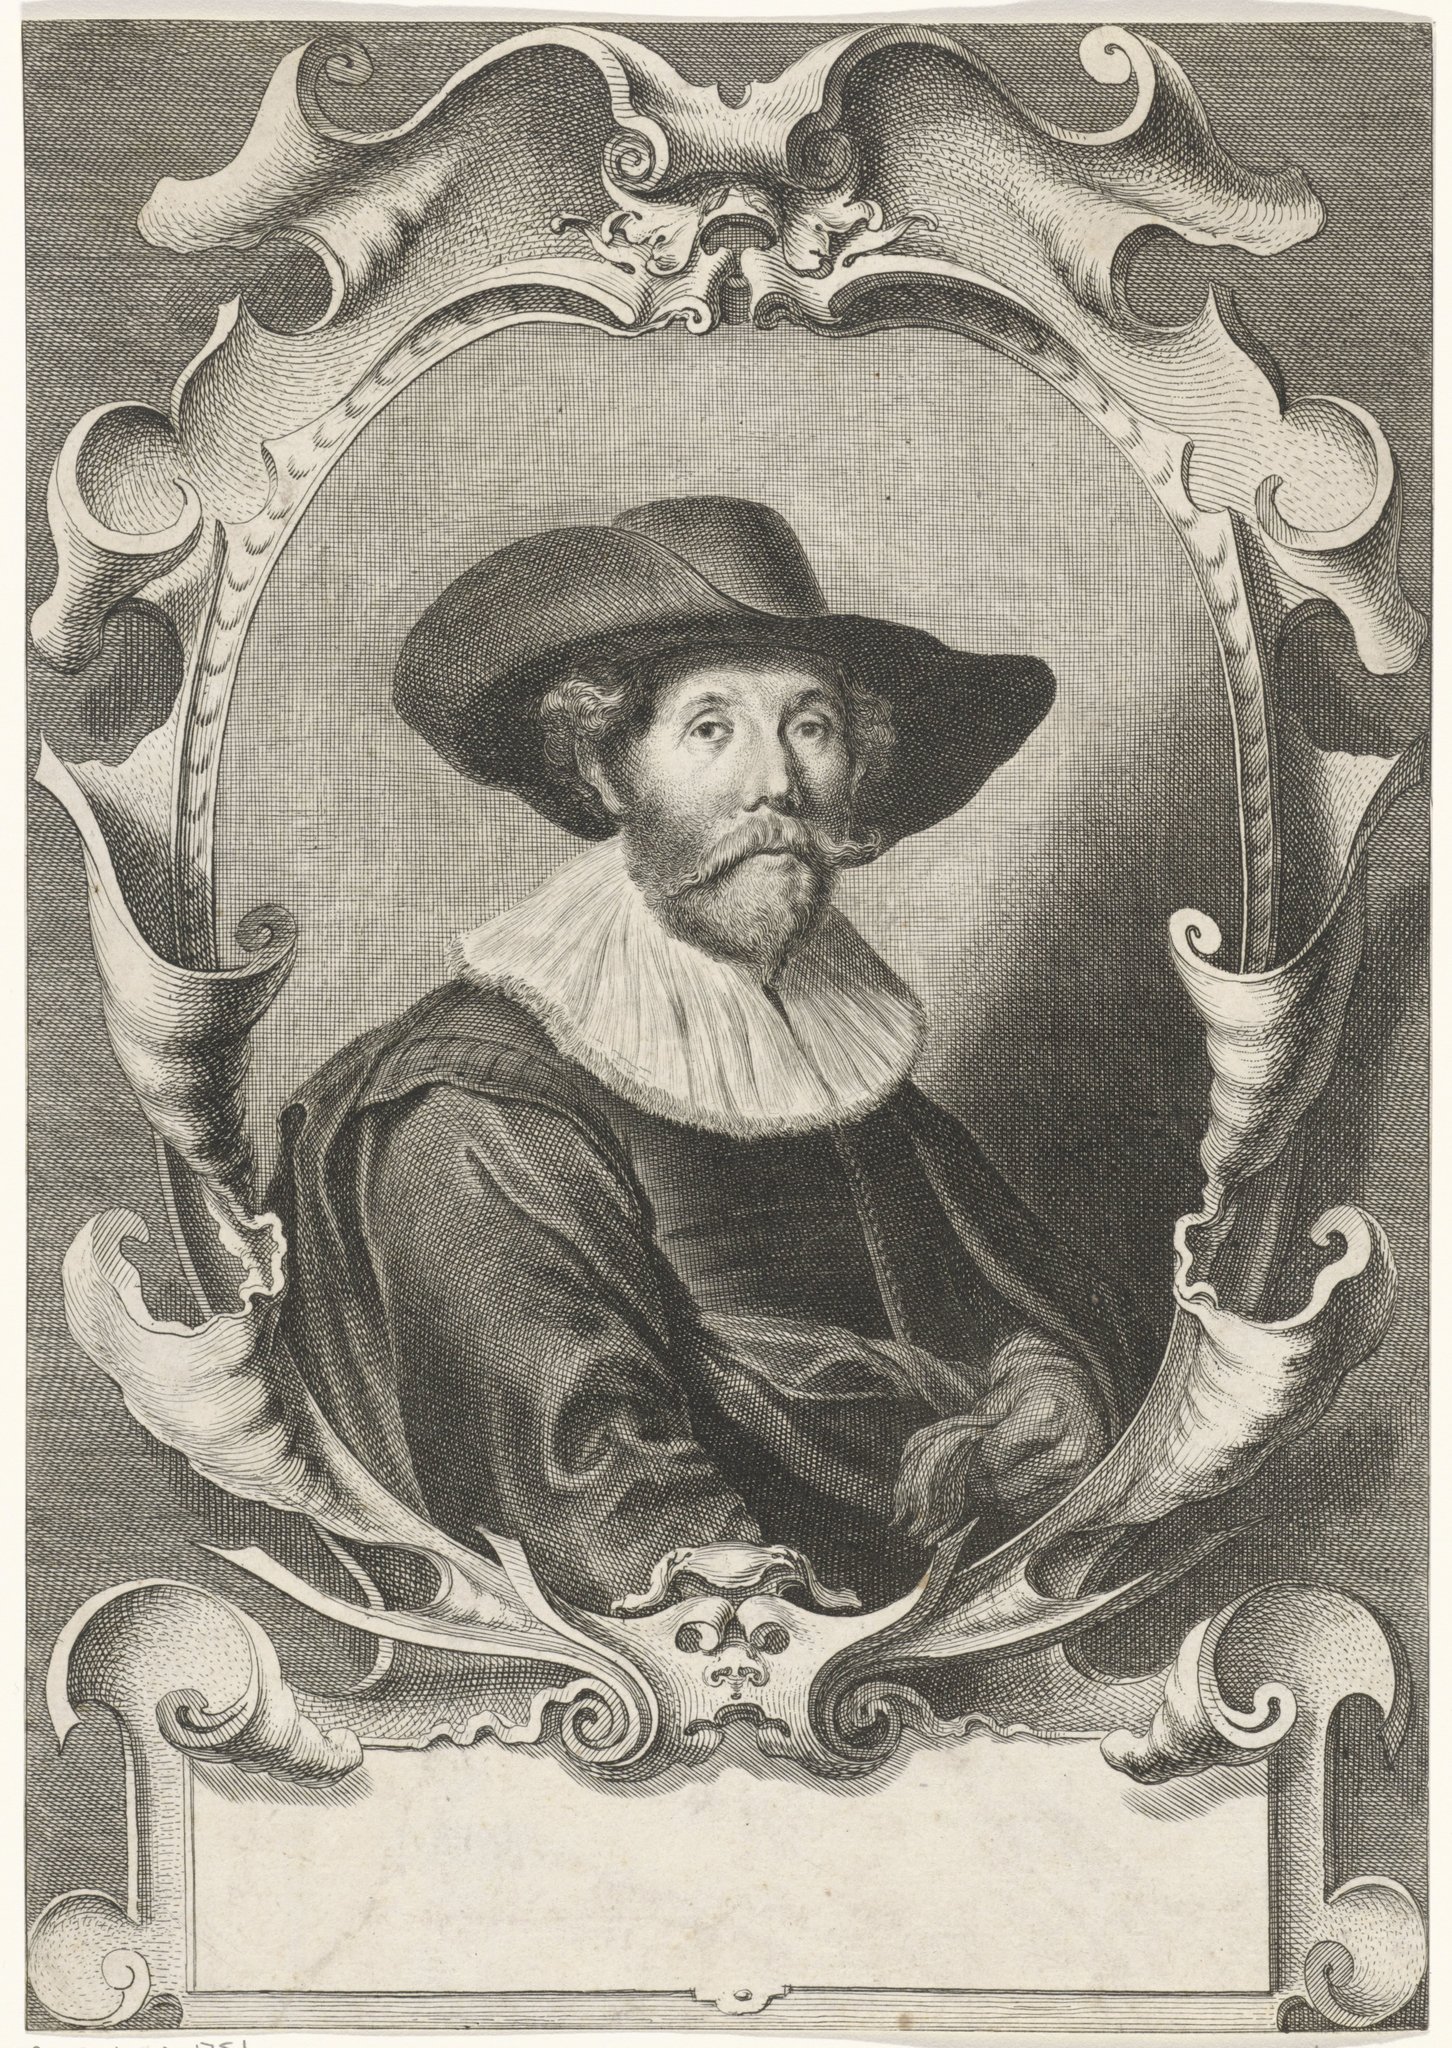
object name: print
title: Portret van Dirck Jansz. van Oirschott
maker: salomon savery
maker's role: print maker, publisher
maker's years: 1594-1683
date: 1610-1665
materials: paper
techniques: engraving, etching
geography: amsterdam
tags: dirck jansz. van oirschott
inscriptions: collector's mark: Lugt 2228, collector's mark: Lugt 2760